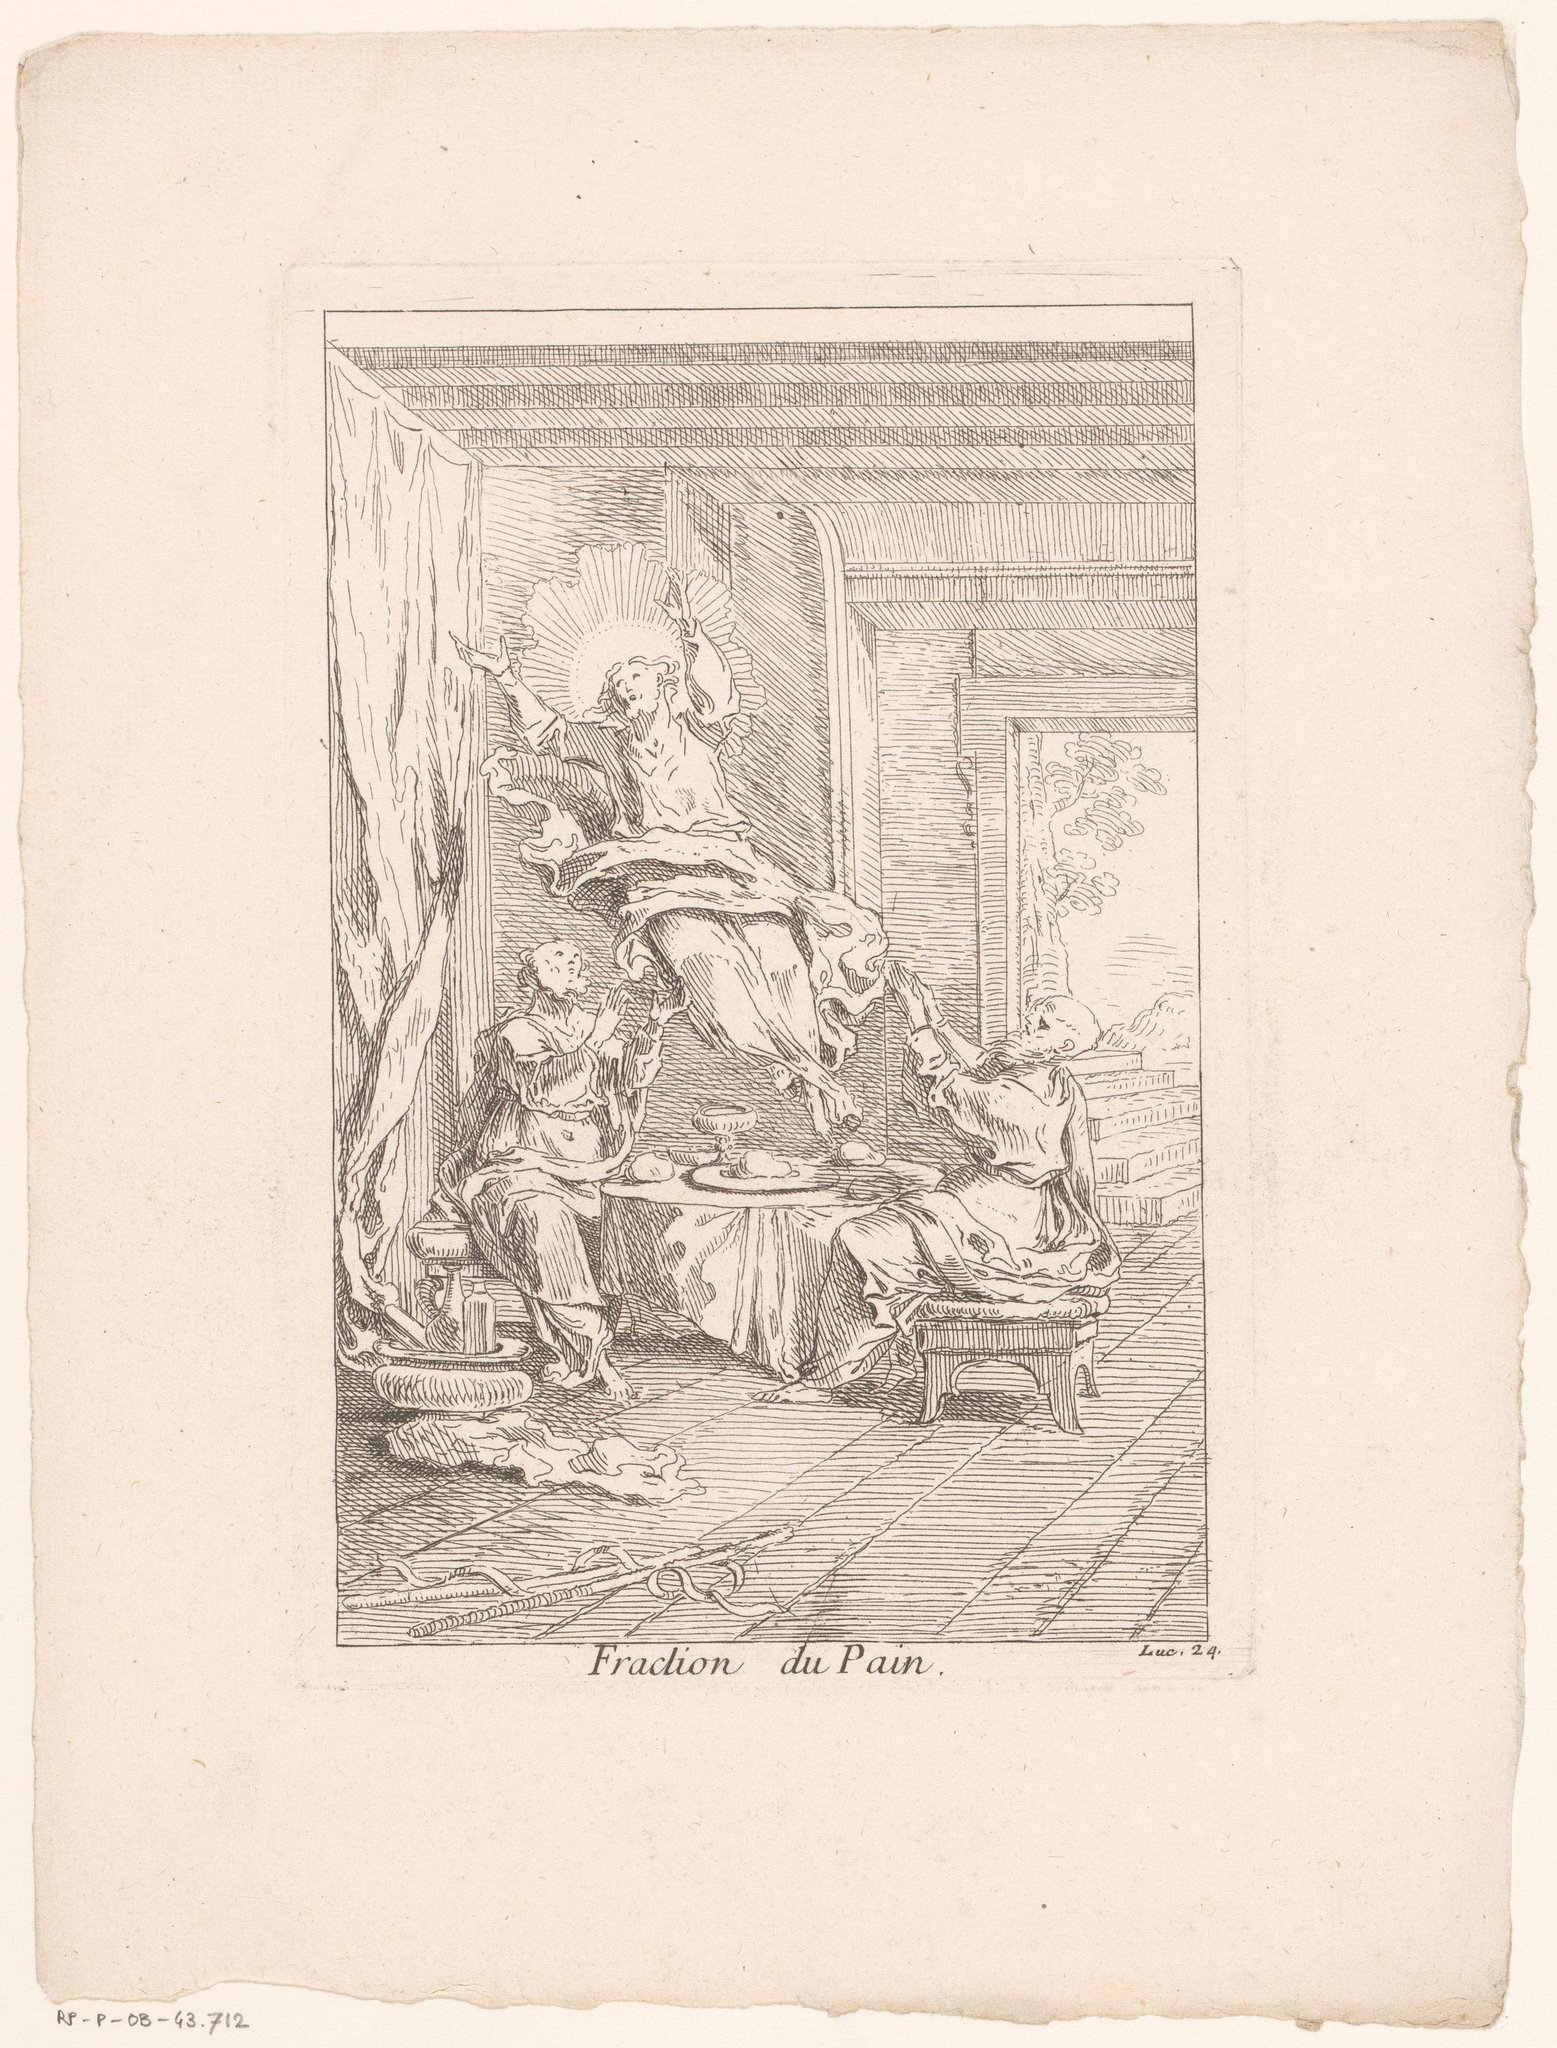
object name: print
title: Emmaüsgangers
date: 1705-1732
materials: paper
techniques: etching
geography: france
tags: the supper at emmaus: christ is recognized while blessing or breaking the bread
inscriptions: collector's mark: Lugt 2228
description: Maakt deel uit van een serie met zestig prenten met als thema het leven van Christus.